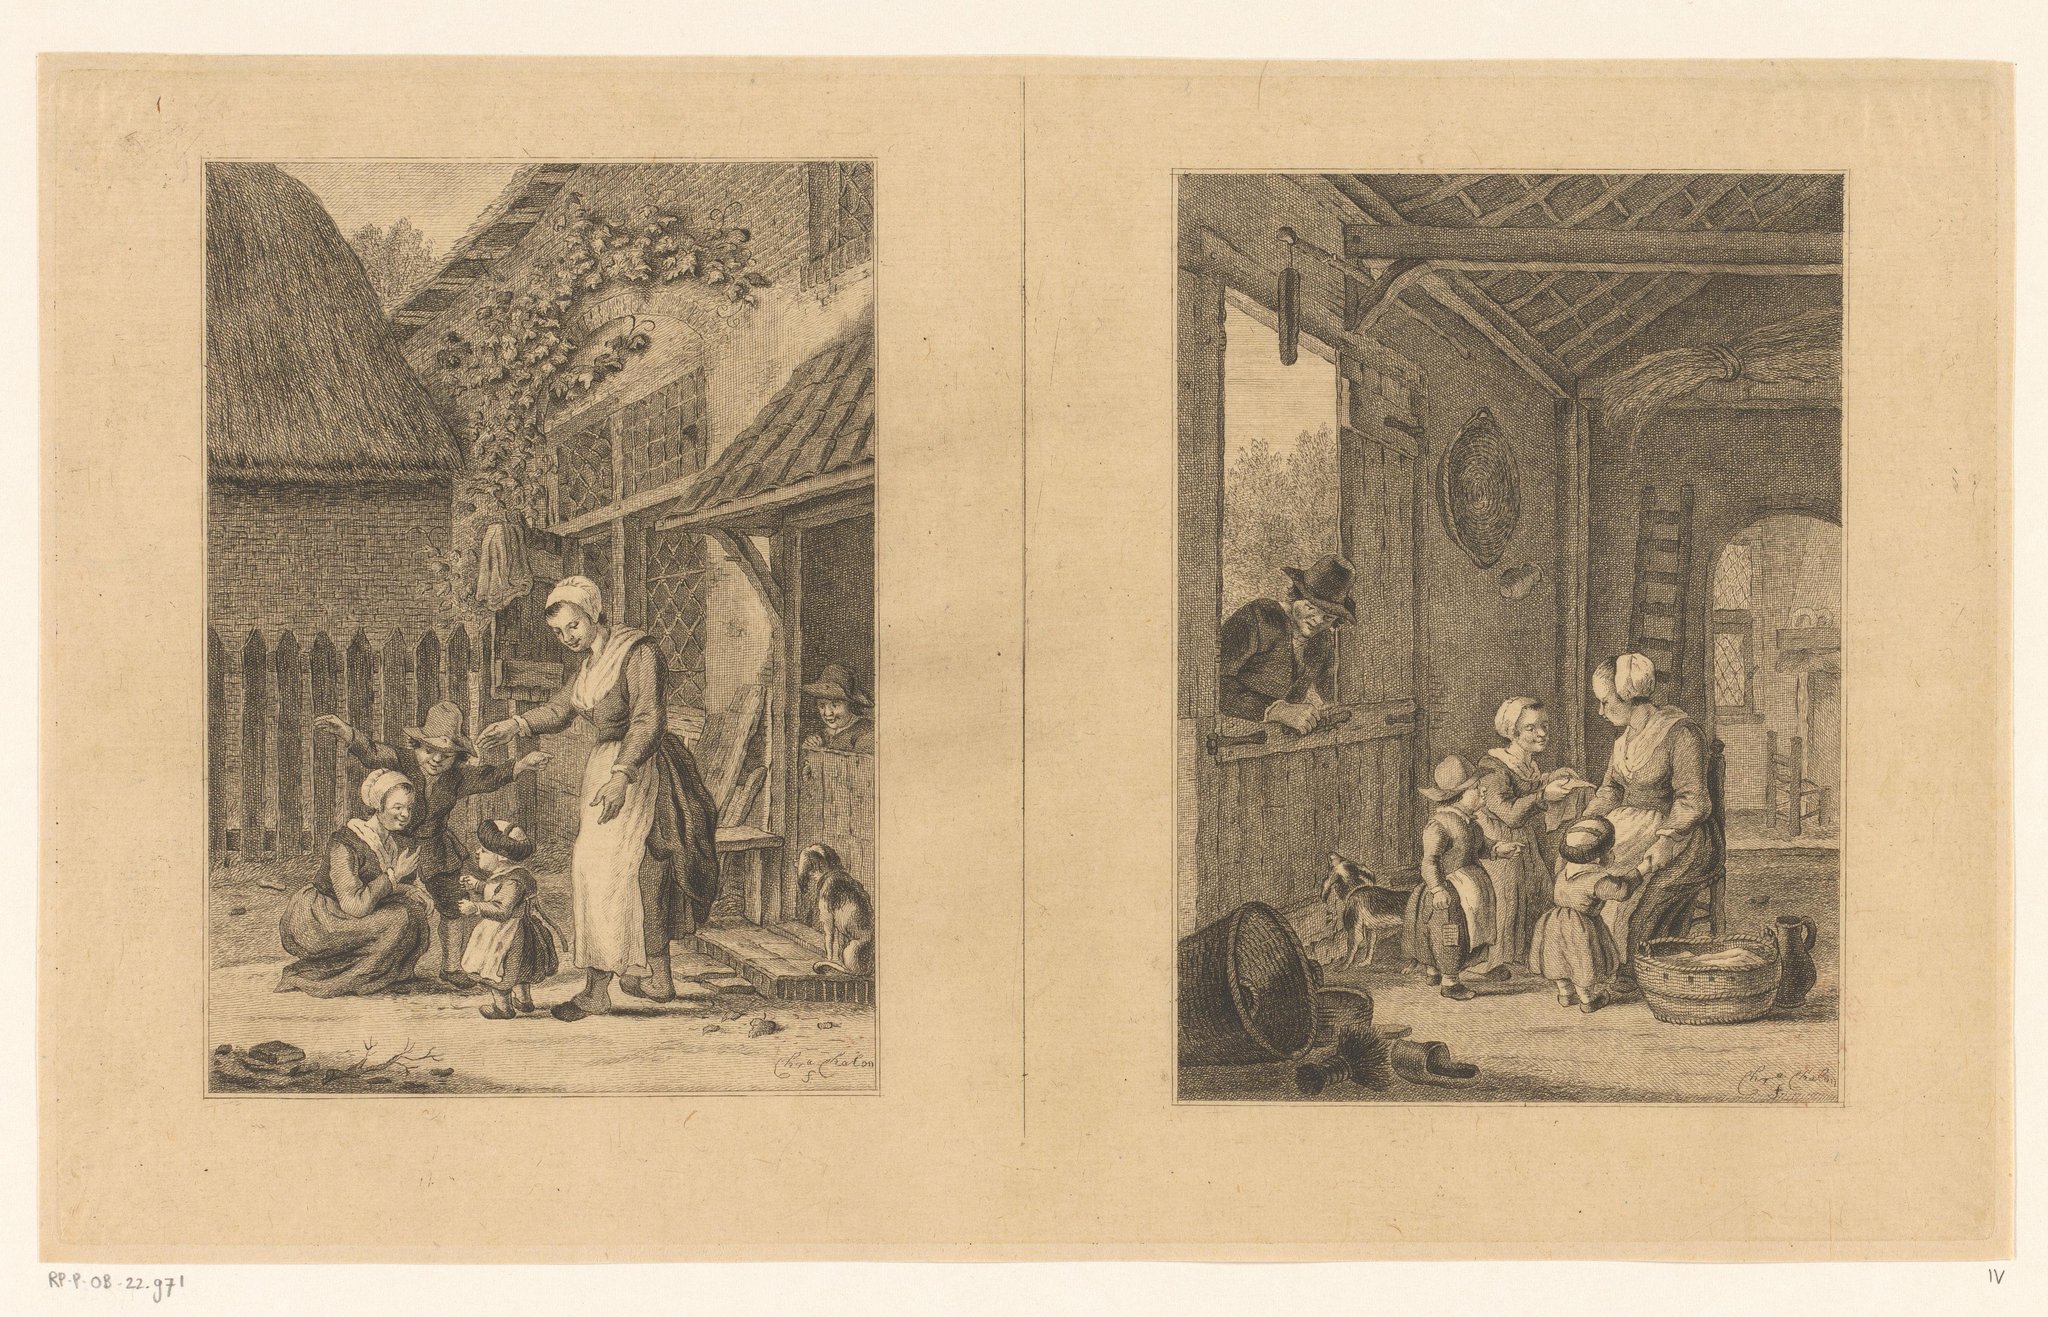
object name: print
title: Twee voorstellingen van een moeder met kinderen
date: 1779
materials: paper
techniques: etching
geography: leiden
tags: mother and baby or young child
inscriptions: collector's mark: Lugt 240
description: Twee voorstellingen van een moeder met kinderen: links een moeder met haar kinderen buiten voor een deuropening en rechts een moeder met haar kinderen in een interieur, een man leunt over een onderdeur.